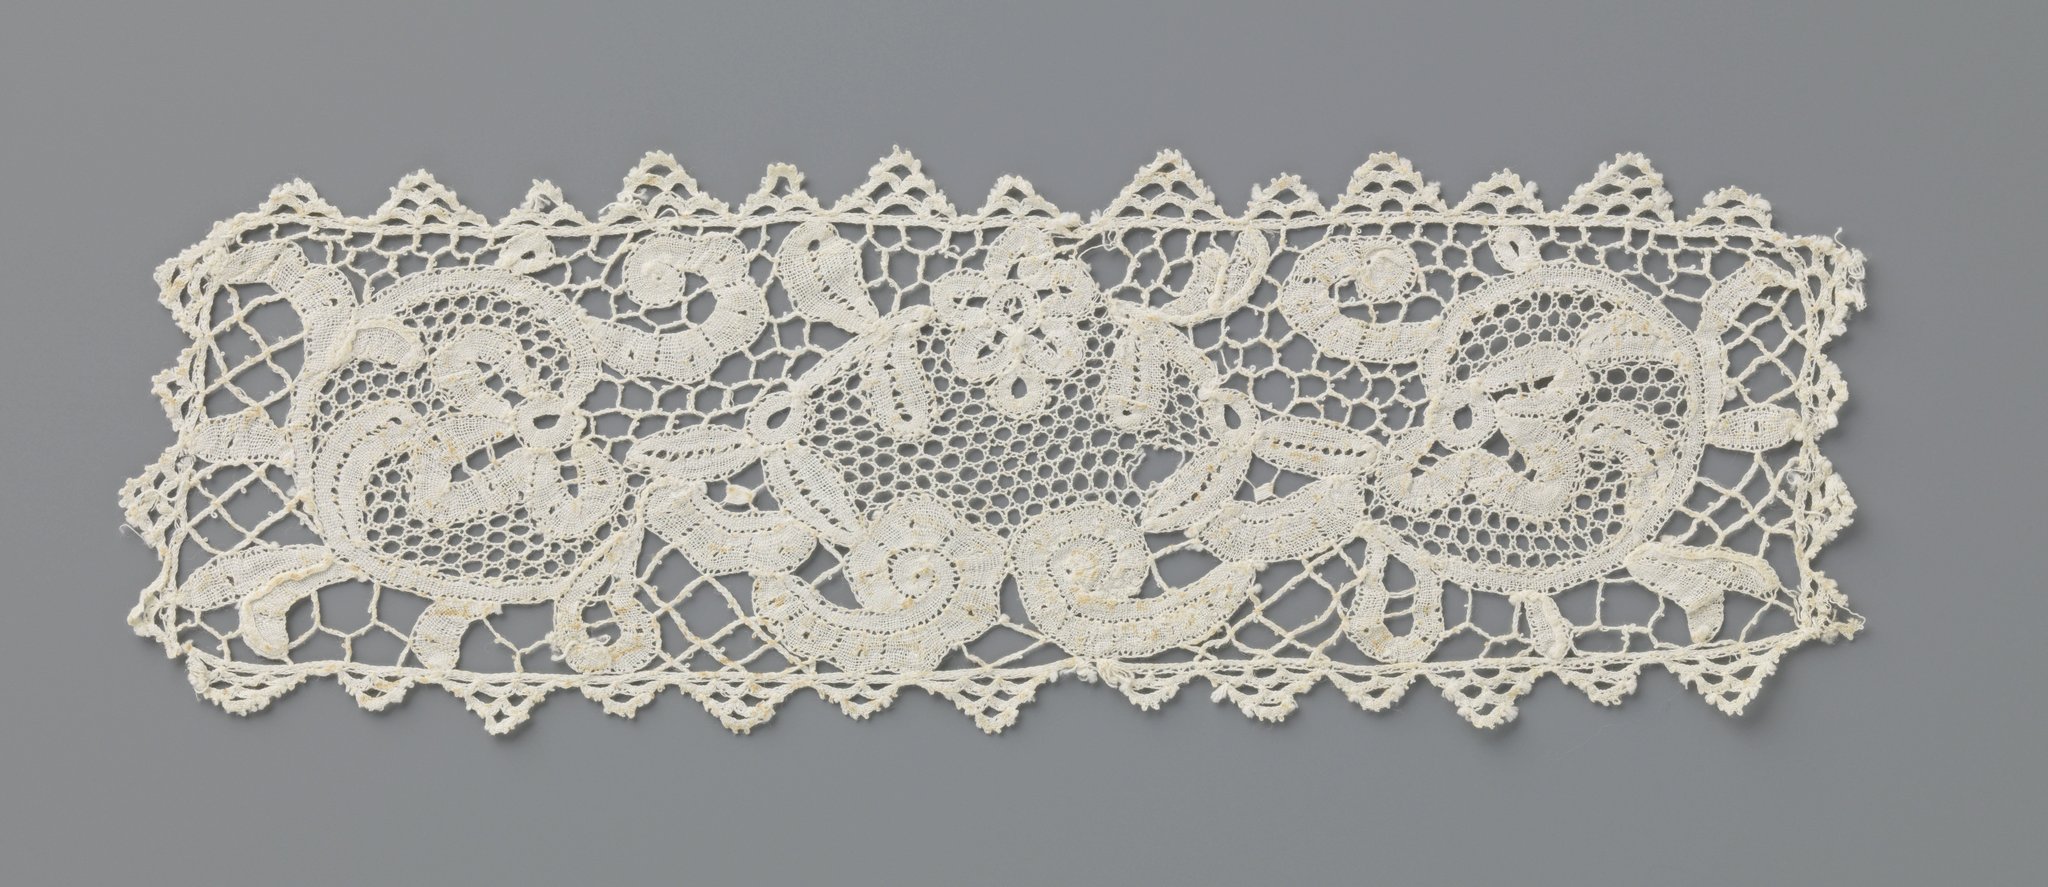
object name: belegstuk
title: Belegstuk van kloskant met voluten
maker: Anonymous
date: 1910-1930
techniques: lace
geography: belgium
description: Belegstuk van naturelkleurig kloskant, mogelijk Vlaamse guipure. Symmetrisch patroon met voluten waaraan drie-, vier- en vijfbladige bloemen ontspringen. Om de motieven heen een gevlochten spijlengrond met picots. Binnen de motieven een honingraatgrond. Afwerking aan alle zijden met uit boogjes opgebouwde driehoekjes.